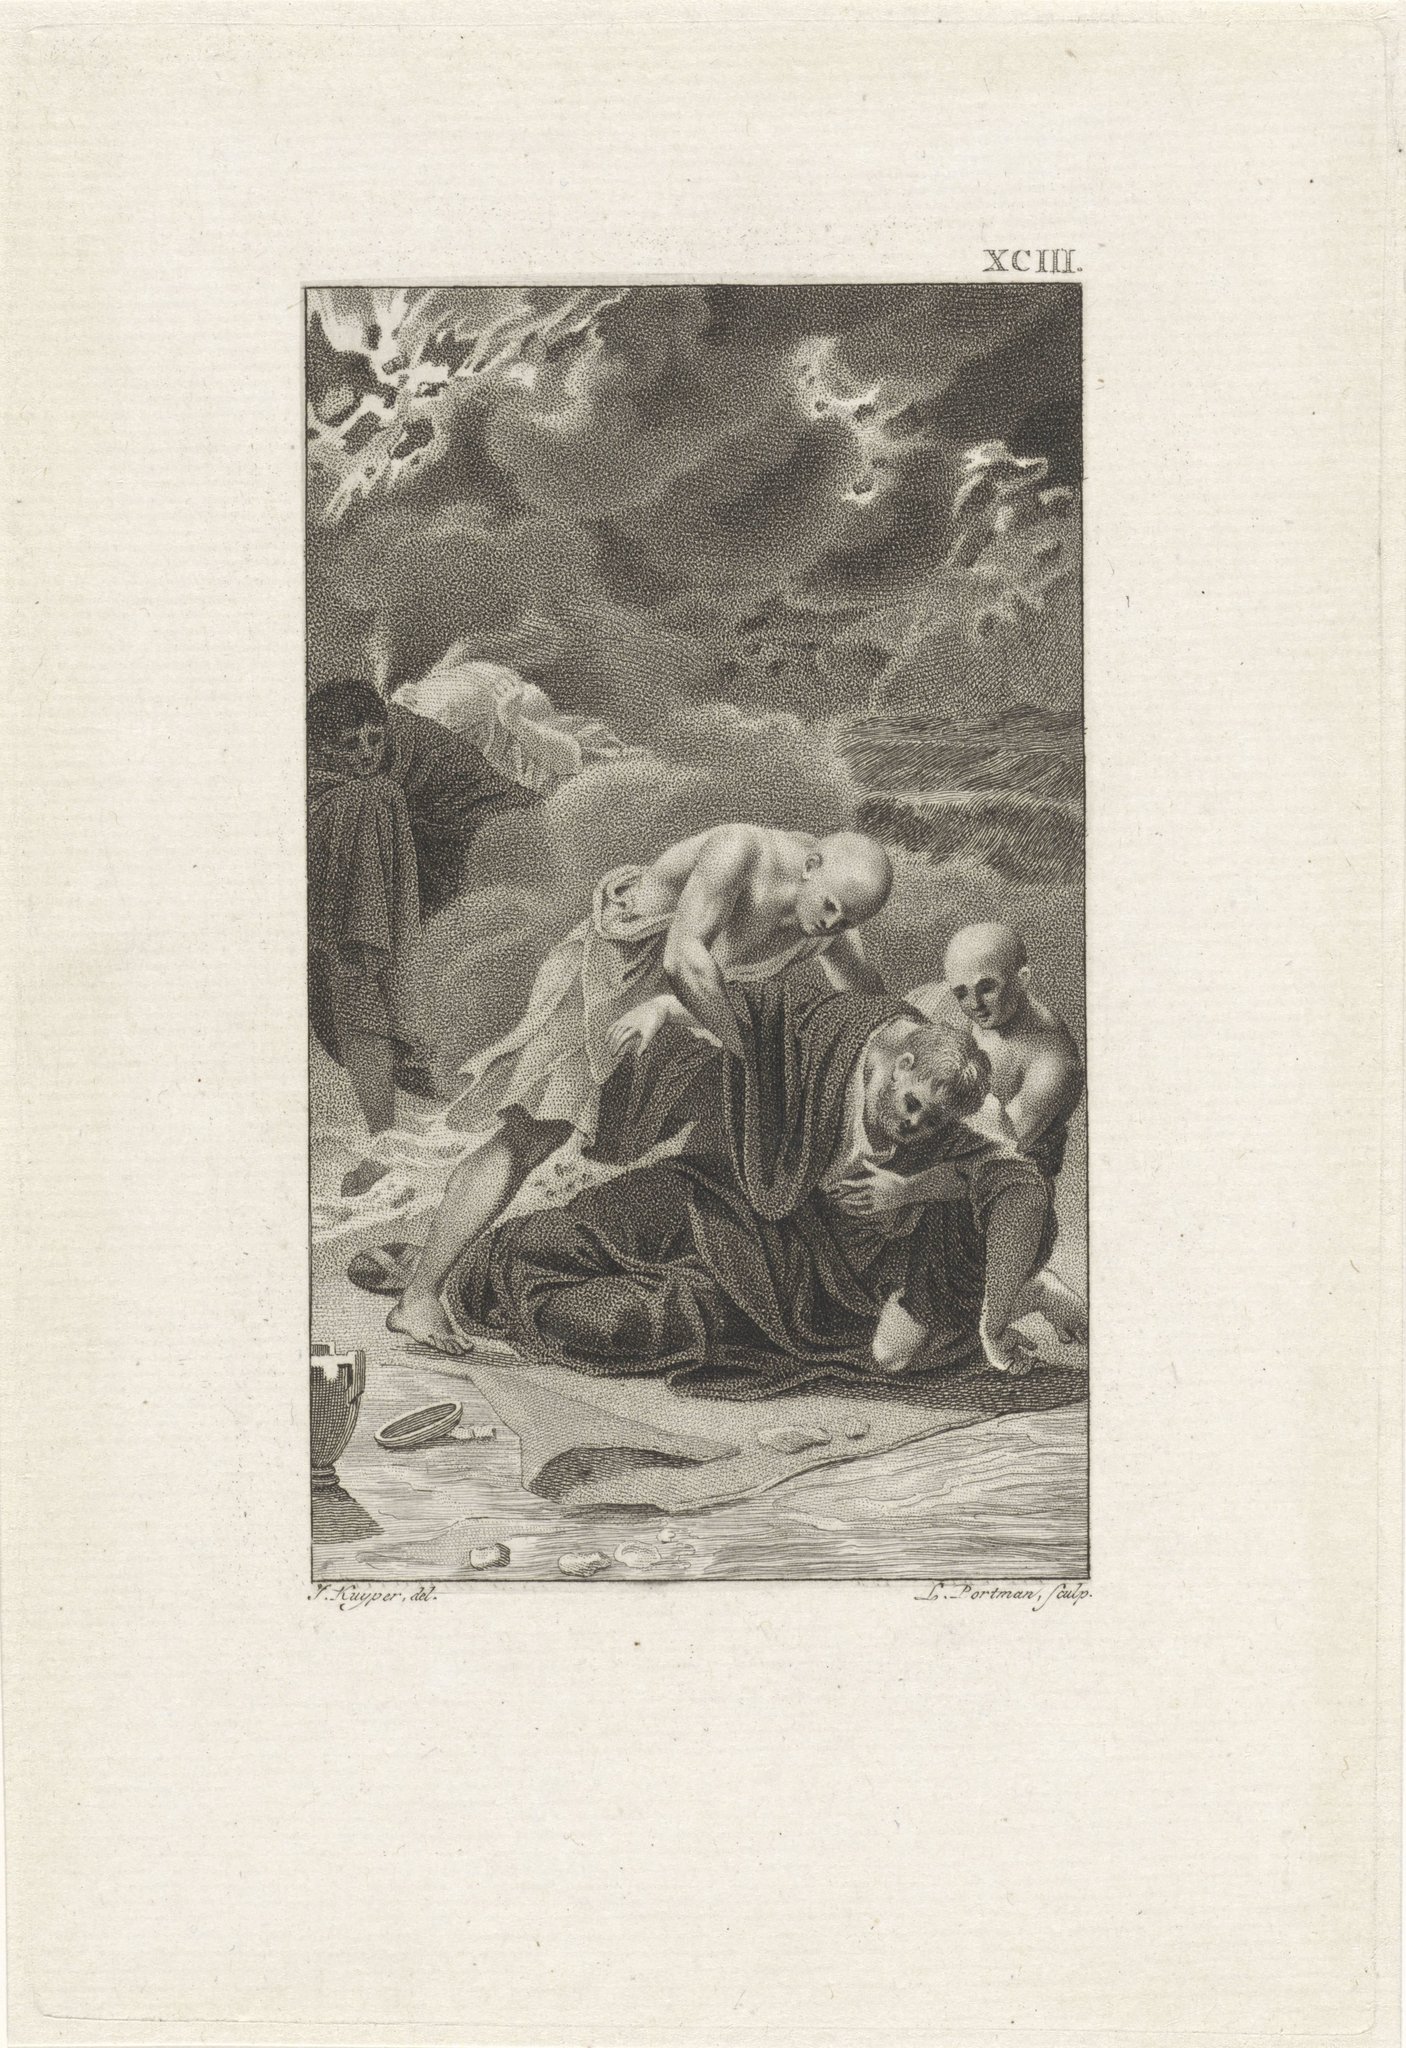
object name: book illustration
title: Dood van Plinius de Oudere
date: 1805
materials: paper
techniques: etching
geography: amsterdam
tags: death of pliny the elder during the eruption of vesuvius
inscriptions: collector's mark: Lugt 2228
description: Gaius Plinius Secundus maior sterft door verstikking tijdens de uitbarsting van de Vesuvius, op 24 augustus 79. Hij werd het slachtoffer van zijn eigen wetenschappelijke belangstelling.